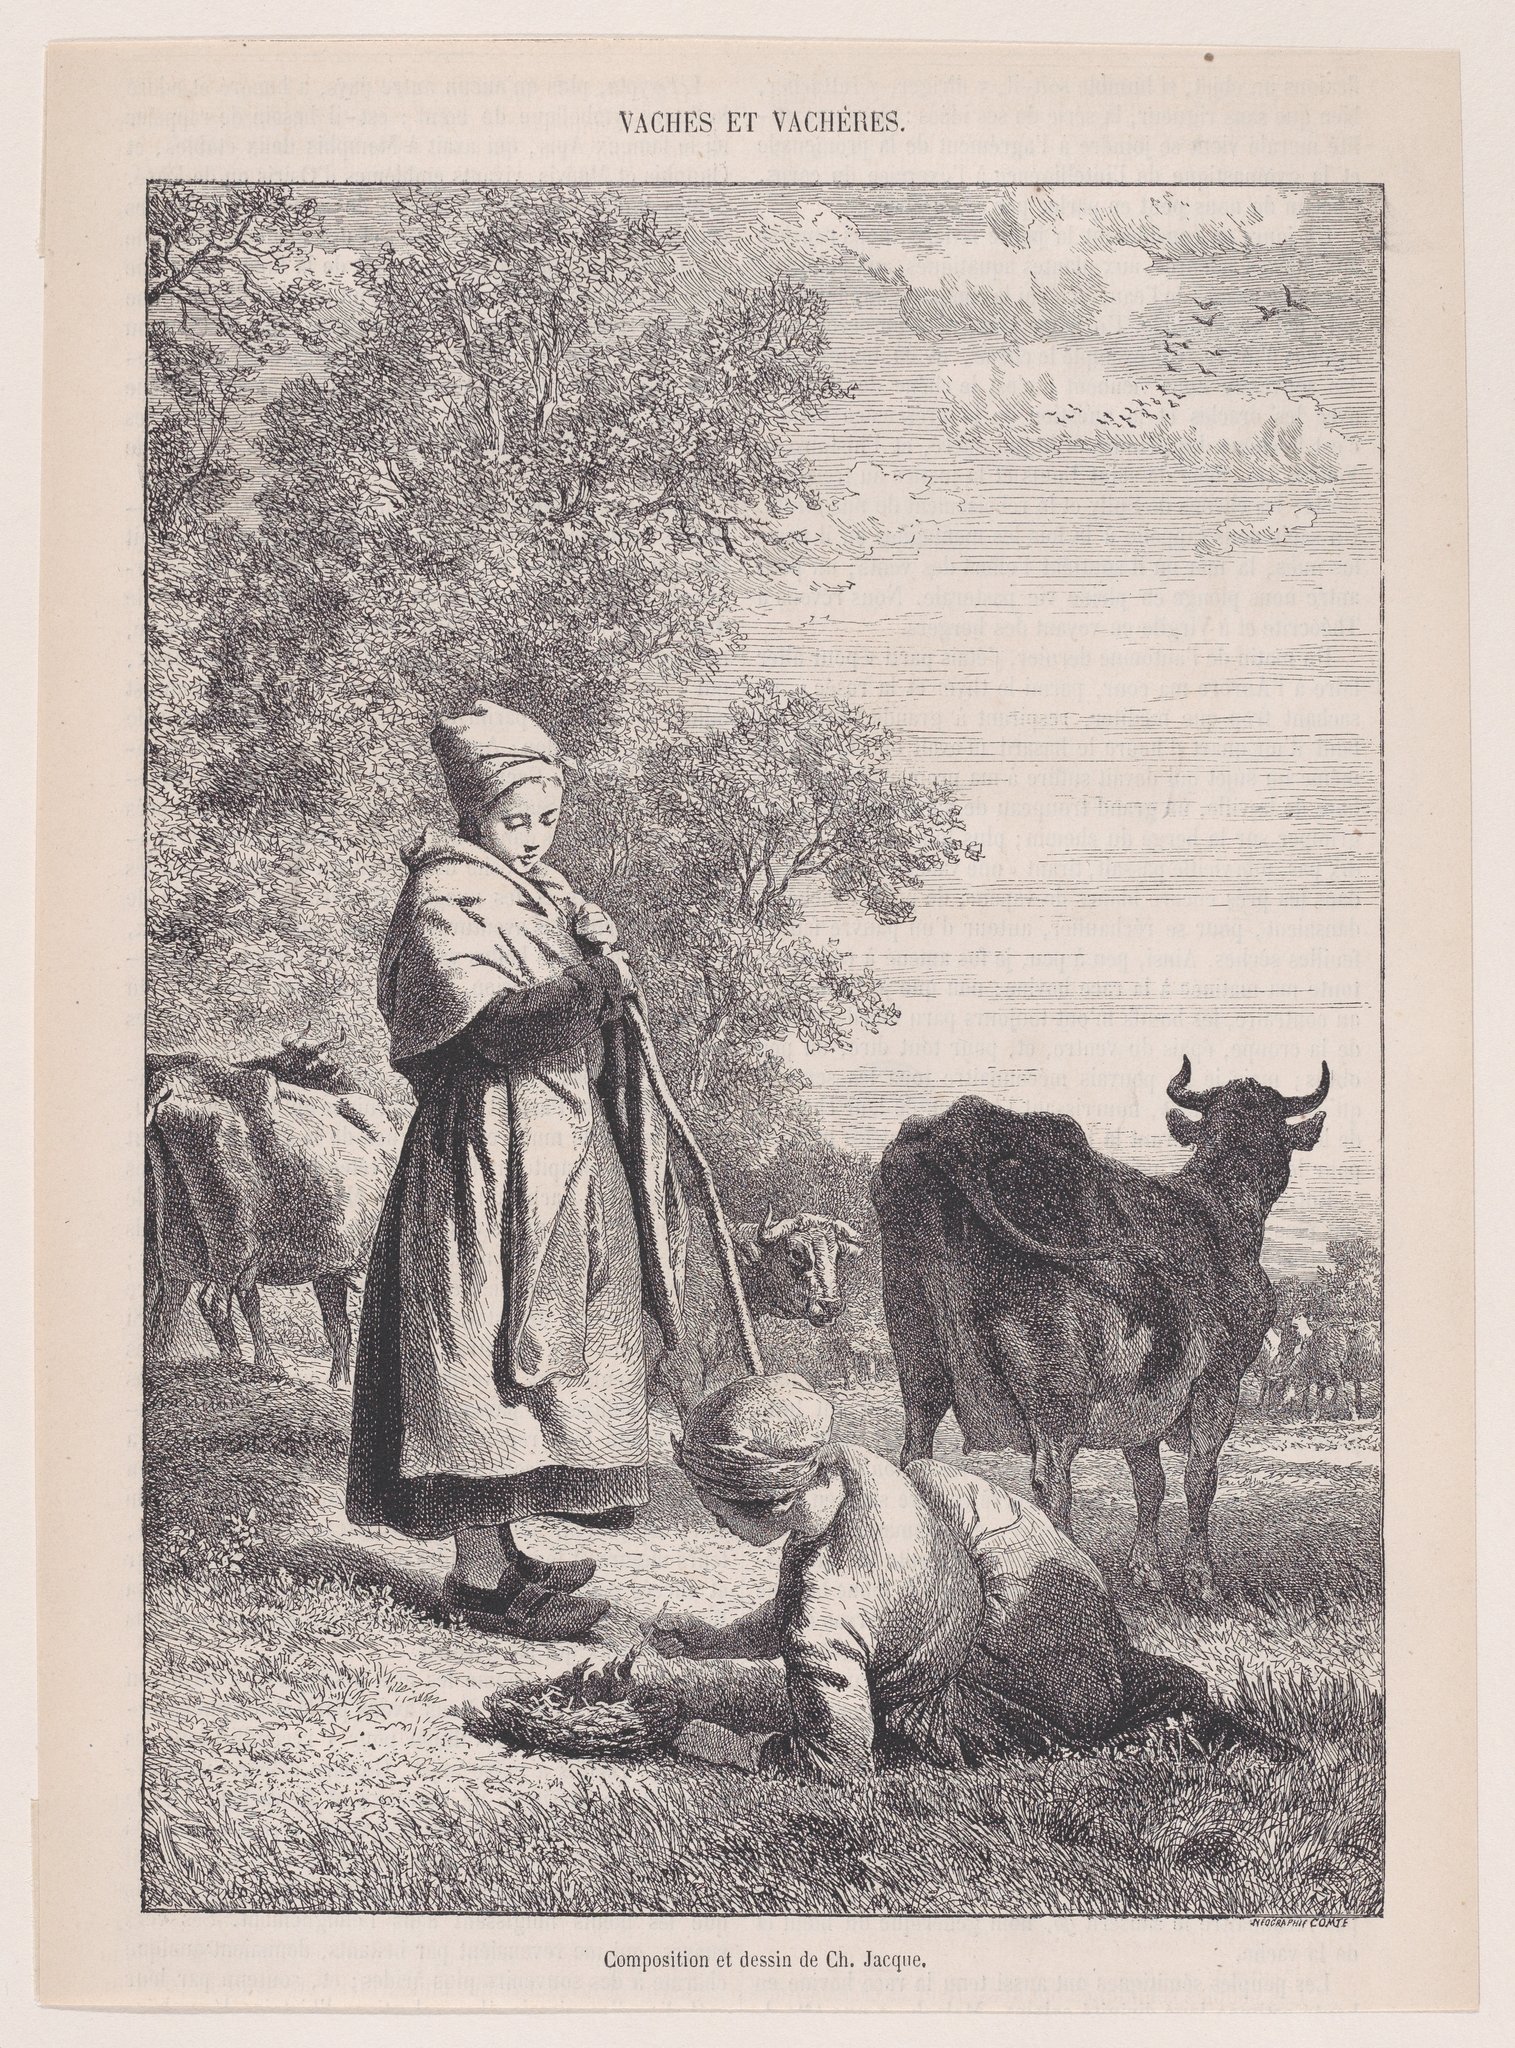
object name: print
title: Cows and Cowherds, from "Le Magasin Pittoresque"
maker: charles émile jacque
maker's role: artist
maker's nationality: french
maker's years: 1813-1894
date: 1852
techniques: relief print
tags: girls,cows